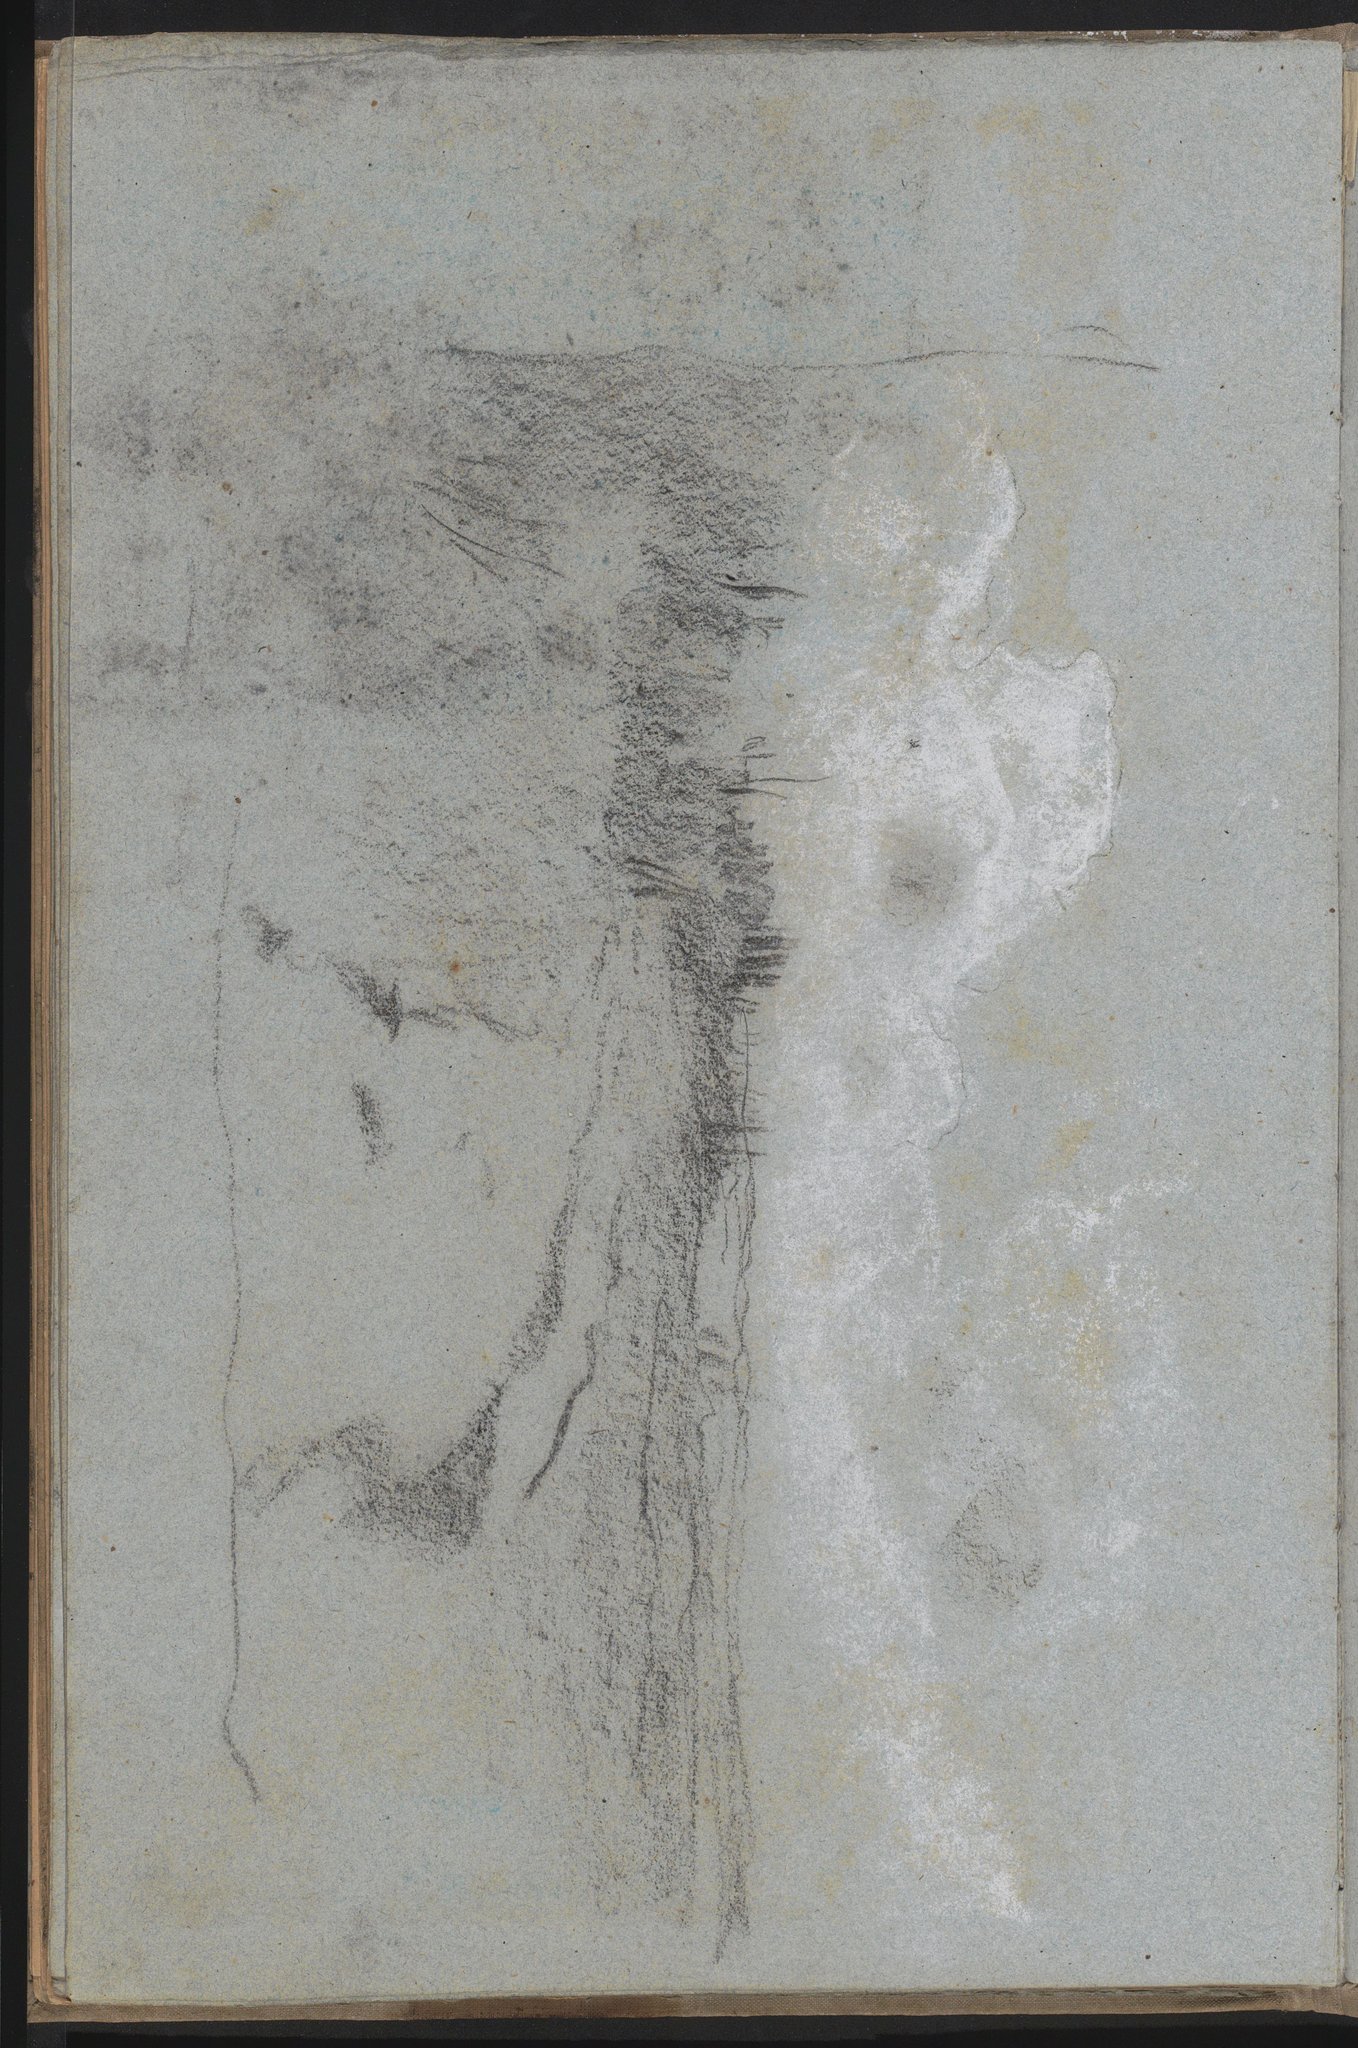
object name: sketchbook leaf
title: Pad door een landschap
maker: willem witsen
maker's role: draughtsman, painter, print maker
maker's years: 1860-1923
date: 1884-1887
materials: chalk, paper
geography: ewijkshoeve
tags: landscapes in the temperate zone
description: Pagina 90 uit een schetsboek met 45 bladen vervaardigd rond de Ewijkshoeve.